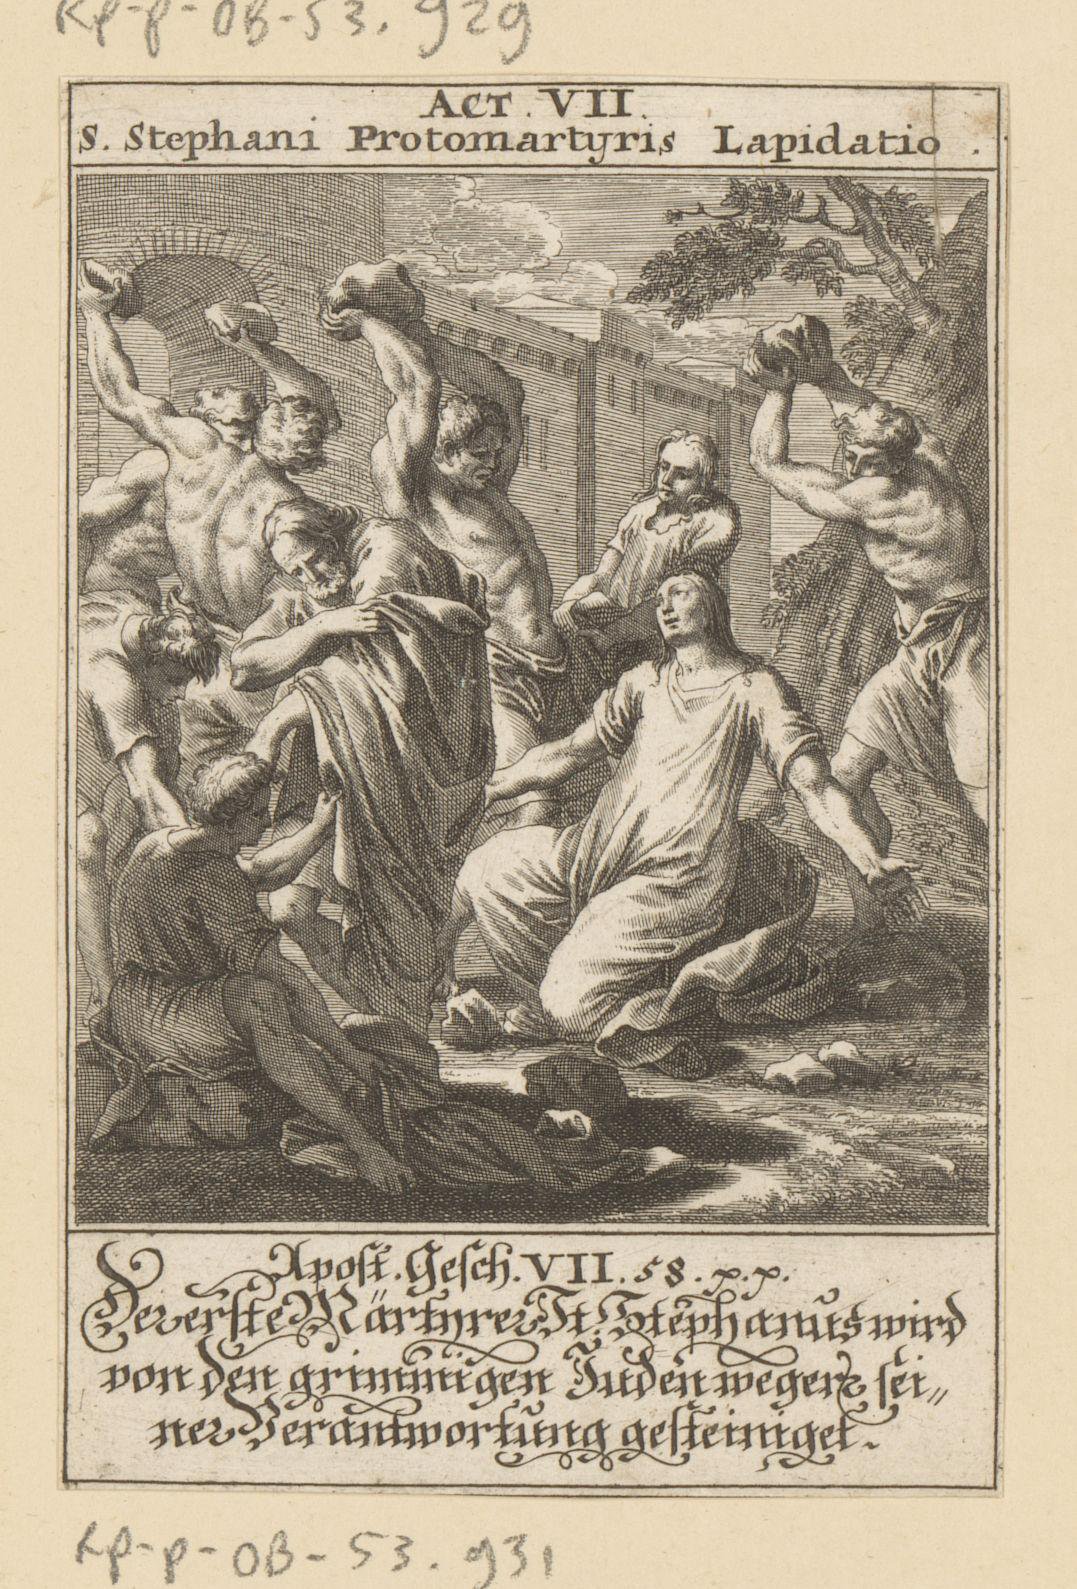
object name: print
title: Heilige Stefanus gestenigd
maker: Anonymous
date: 1697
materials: paper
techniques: etching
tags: the stoning of stephen; the witnesses lay down their clothes at saul's feet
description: Prent ook gebruikt in: Biblia ectypa : Bildnussen auss Heiliger Schrifft. Regensburg: Chr. Wiegel, 1697.